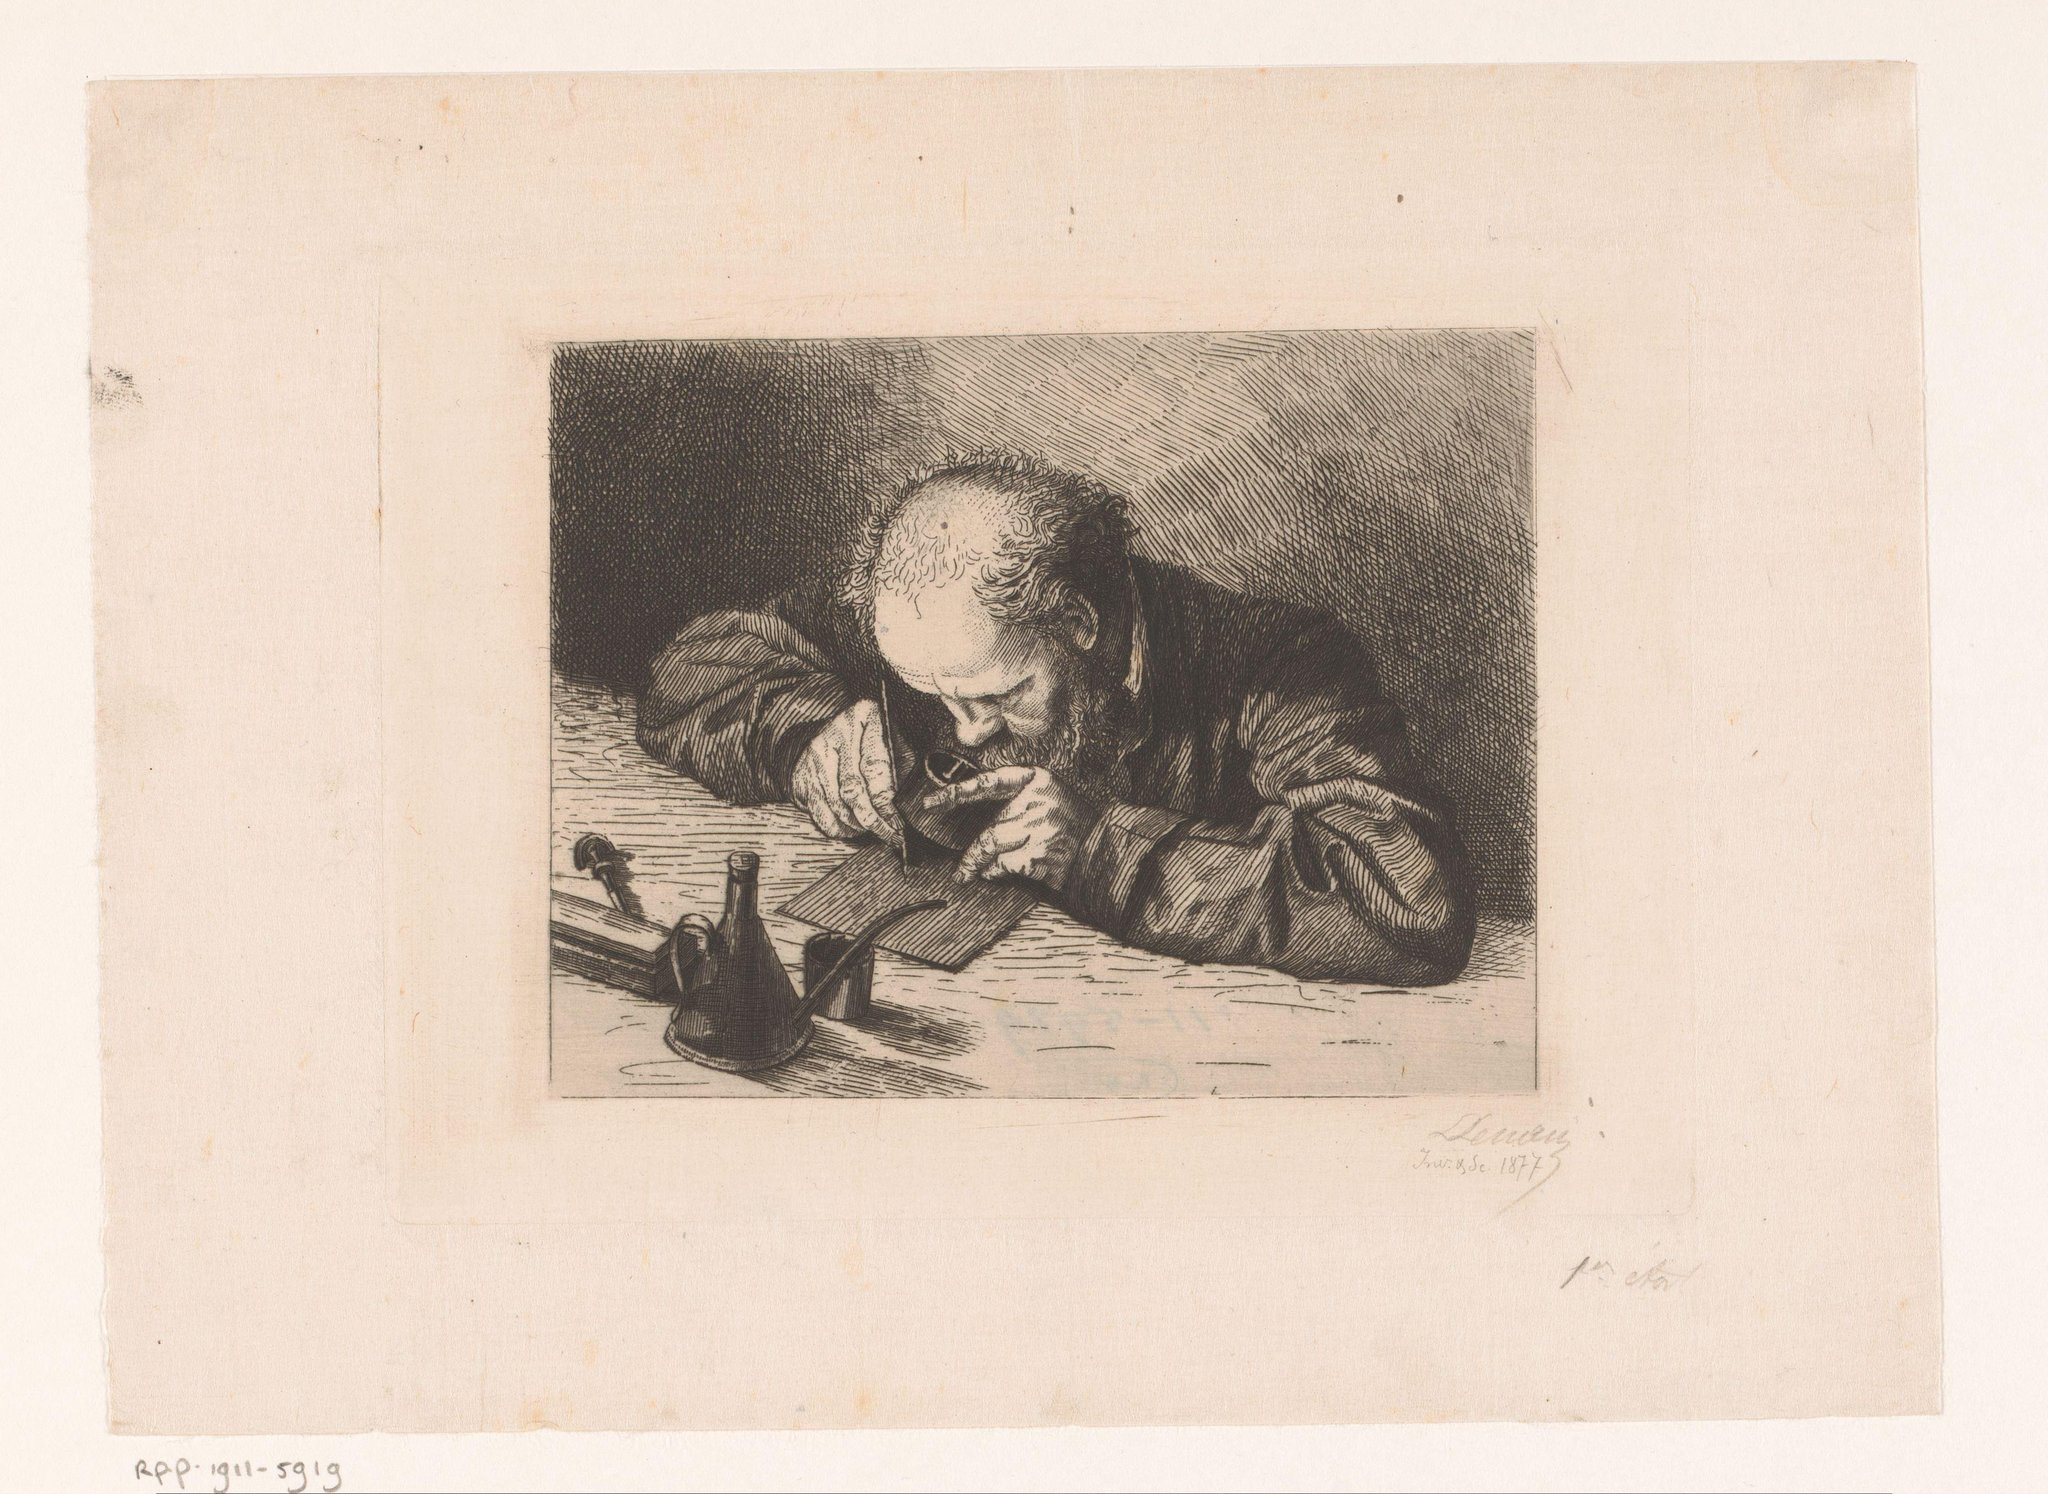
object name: print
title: Graficus aan het werk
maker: louis le nain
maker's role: print maker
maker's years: 1851-1939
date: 1877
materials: paper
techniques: drypoint, etching, intaglio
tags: graphic artist (+ artist at work)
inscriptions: collector's mark: Lugt 2228, inscription: ‘LLenain inv&sc 1877, 1e état’